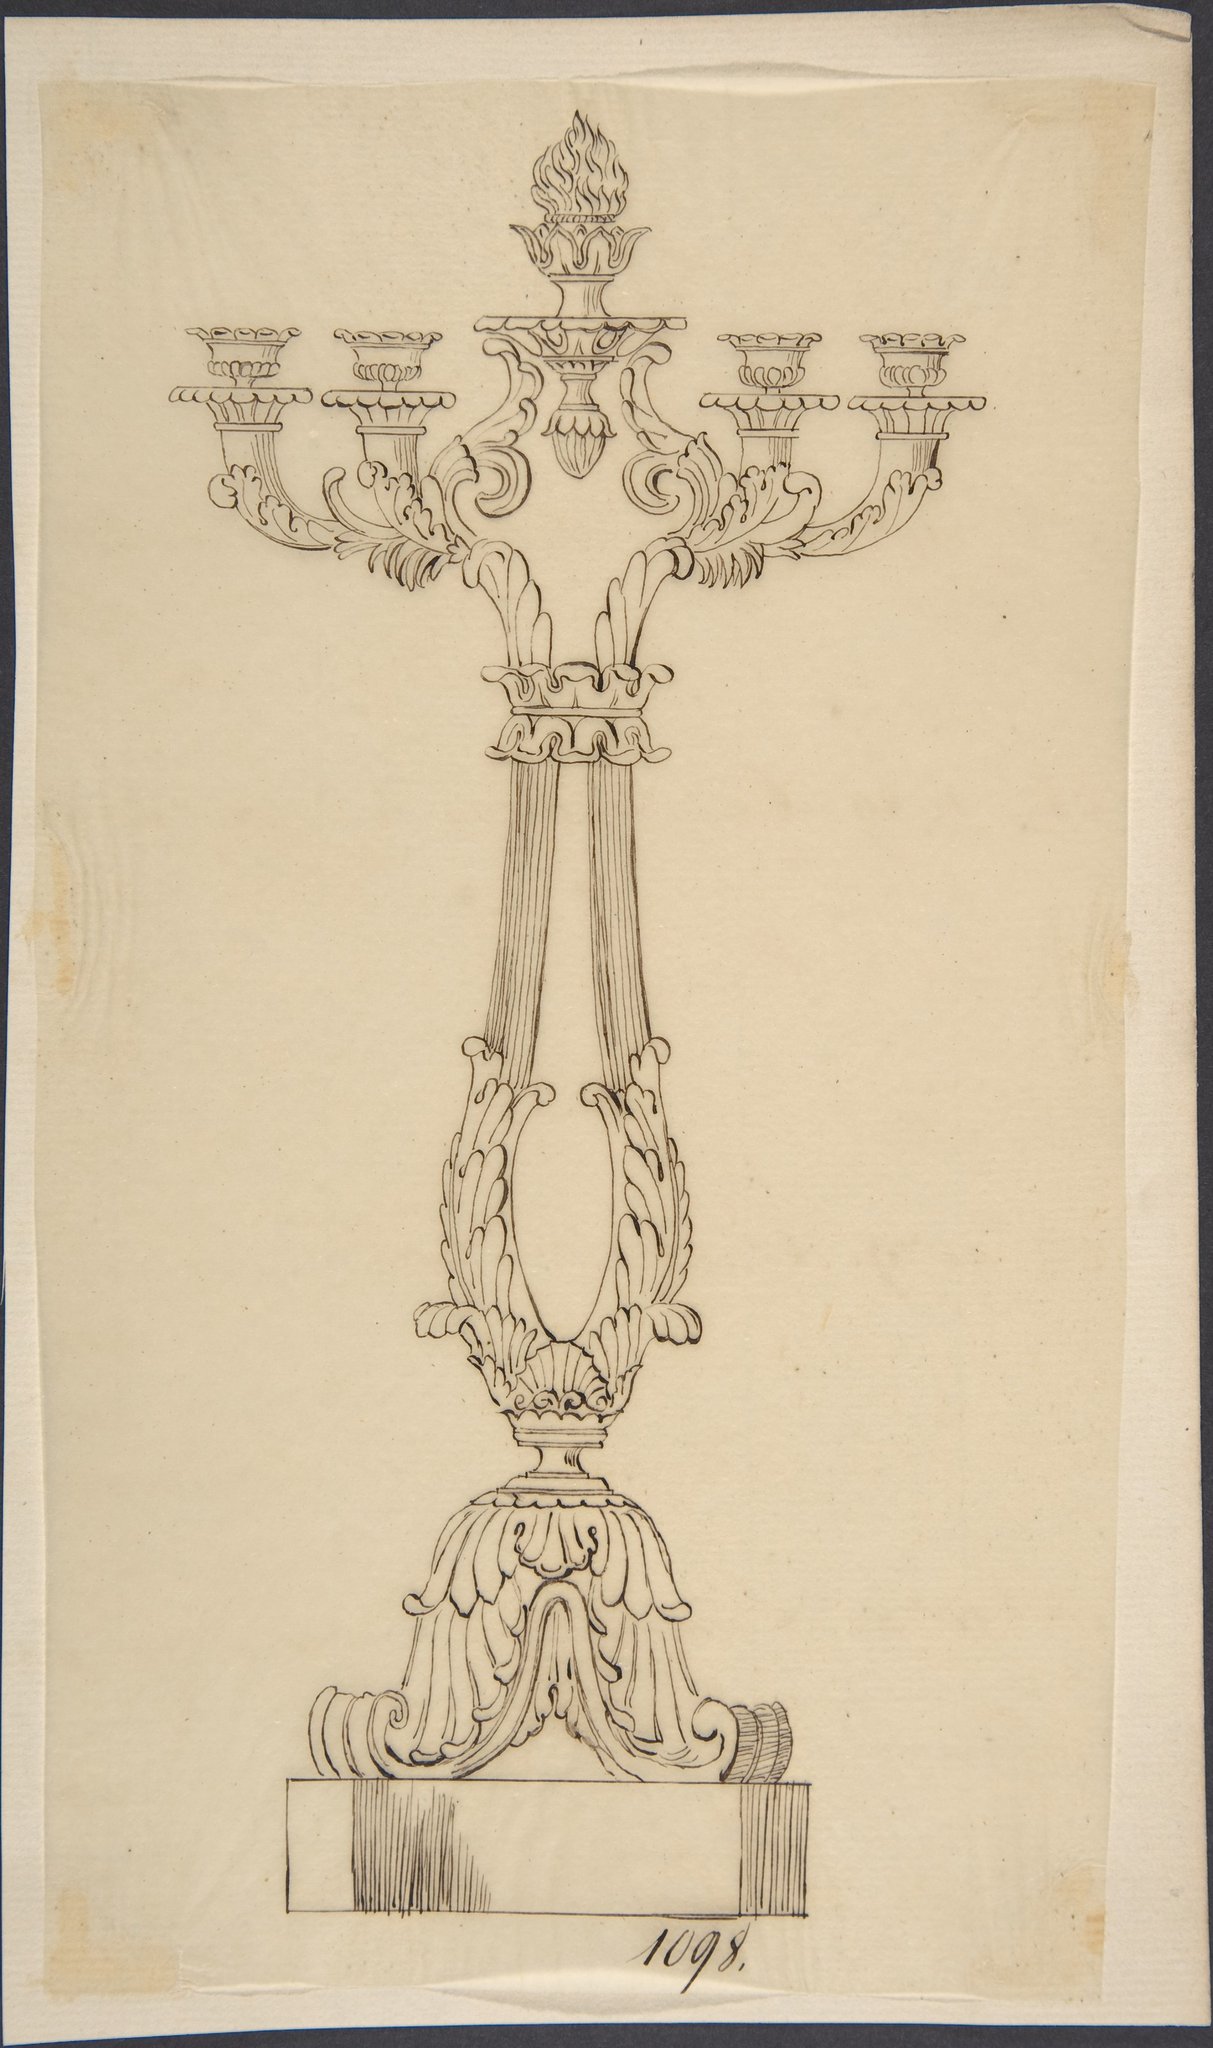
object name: drawing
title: Design for a Candelabra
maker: anonymous, french, 19th century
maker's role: artist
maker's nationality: french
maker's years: 1800-1900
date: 1801-1900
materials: ink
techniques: pen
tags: candelabra